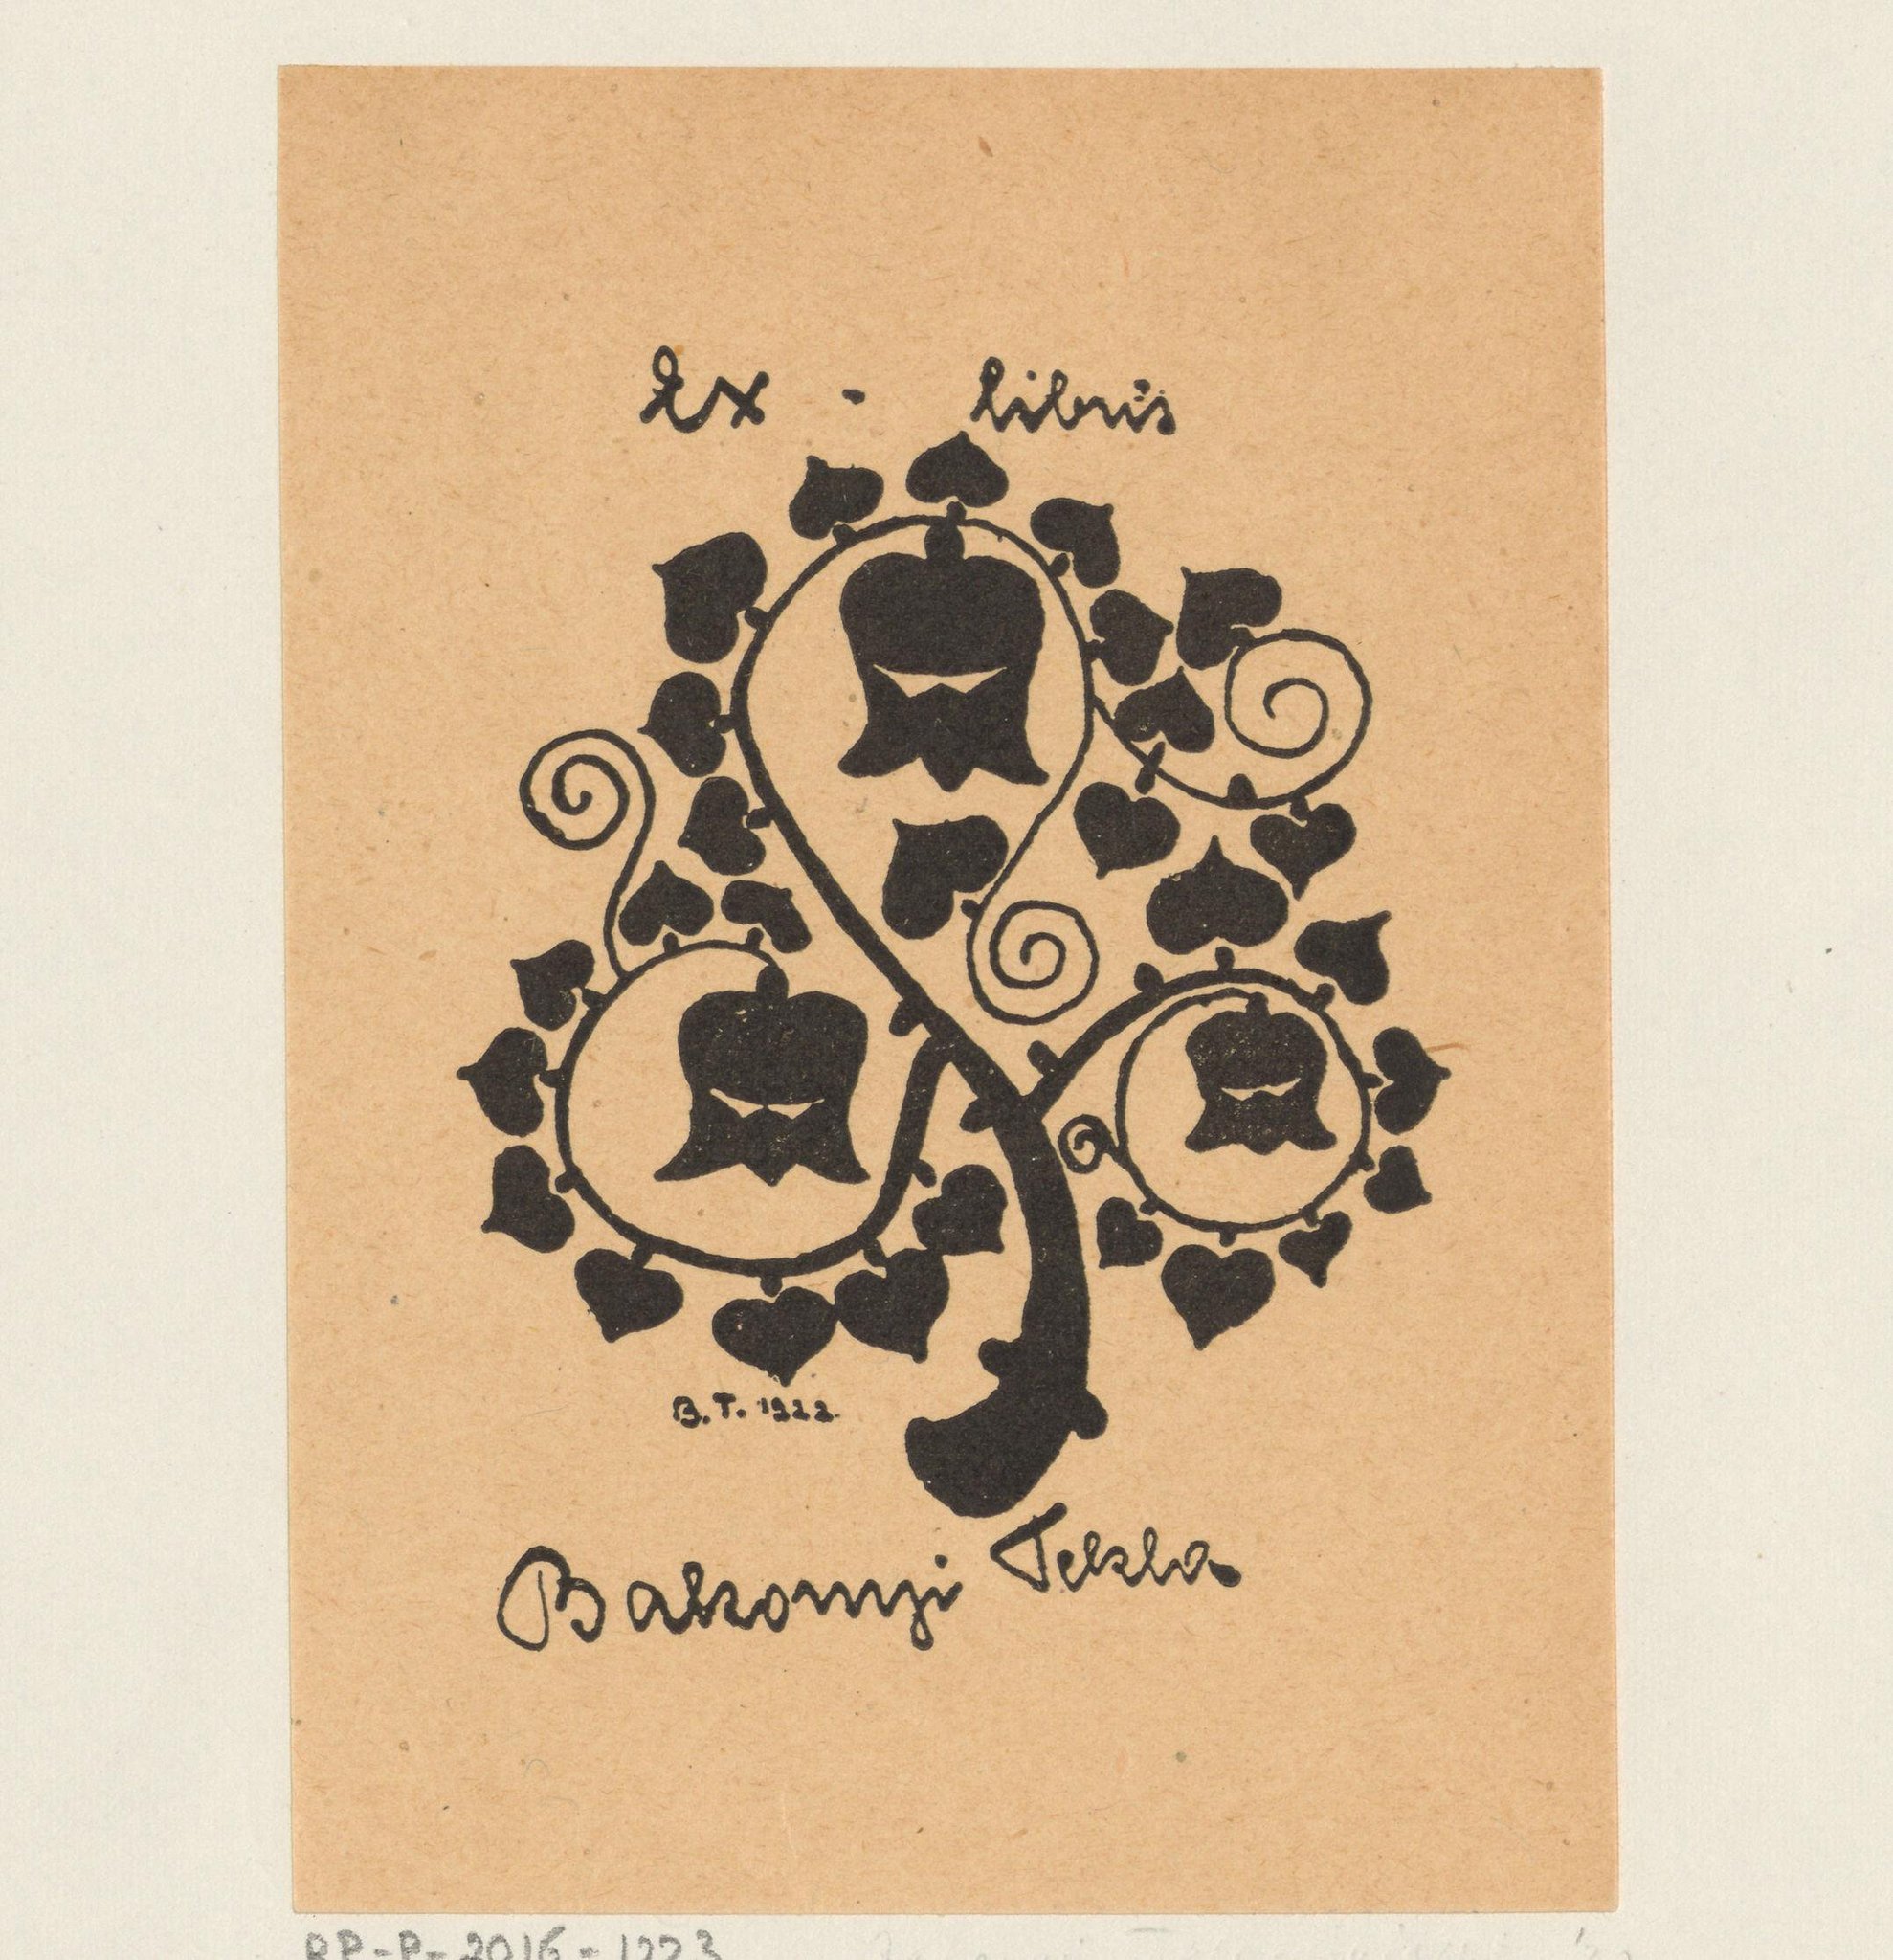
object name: bookplate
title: Ex libris van Bakonyi Tekla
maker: tekla ösztreicher-bakonyi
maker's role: print maker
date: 1922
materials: paper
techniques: printing block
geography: hungary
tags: print maker, tekla ösztreicher-bakonyi, ornament derived from plant forms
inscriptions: date